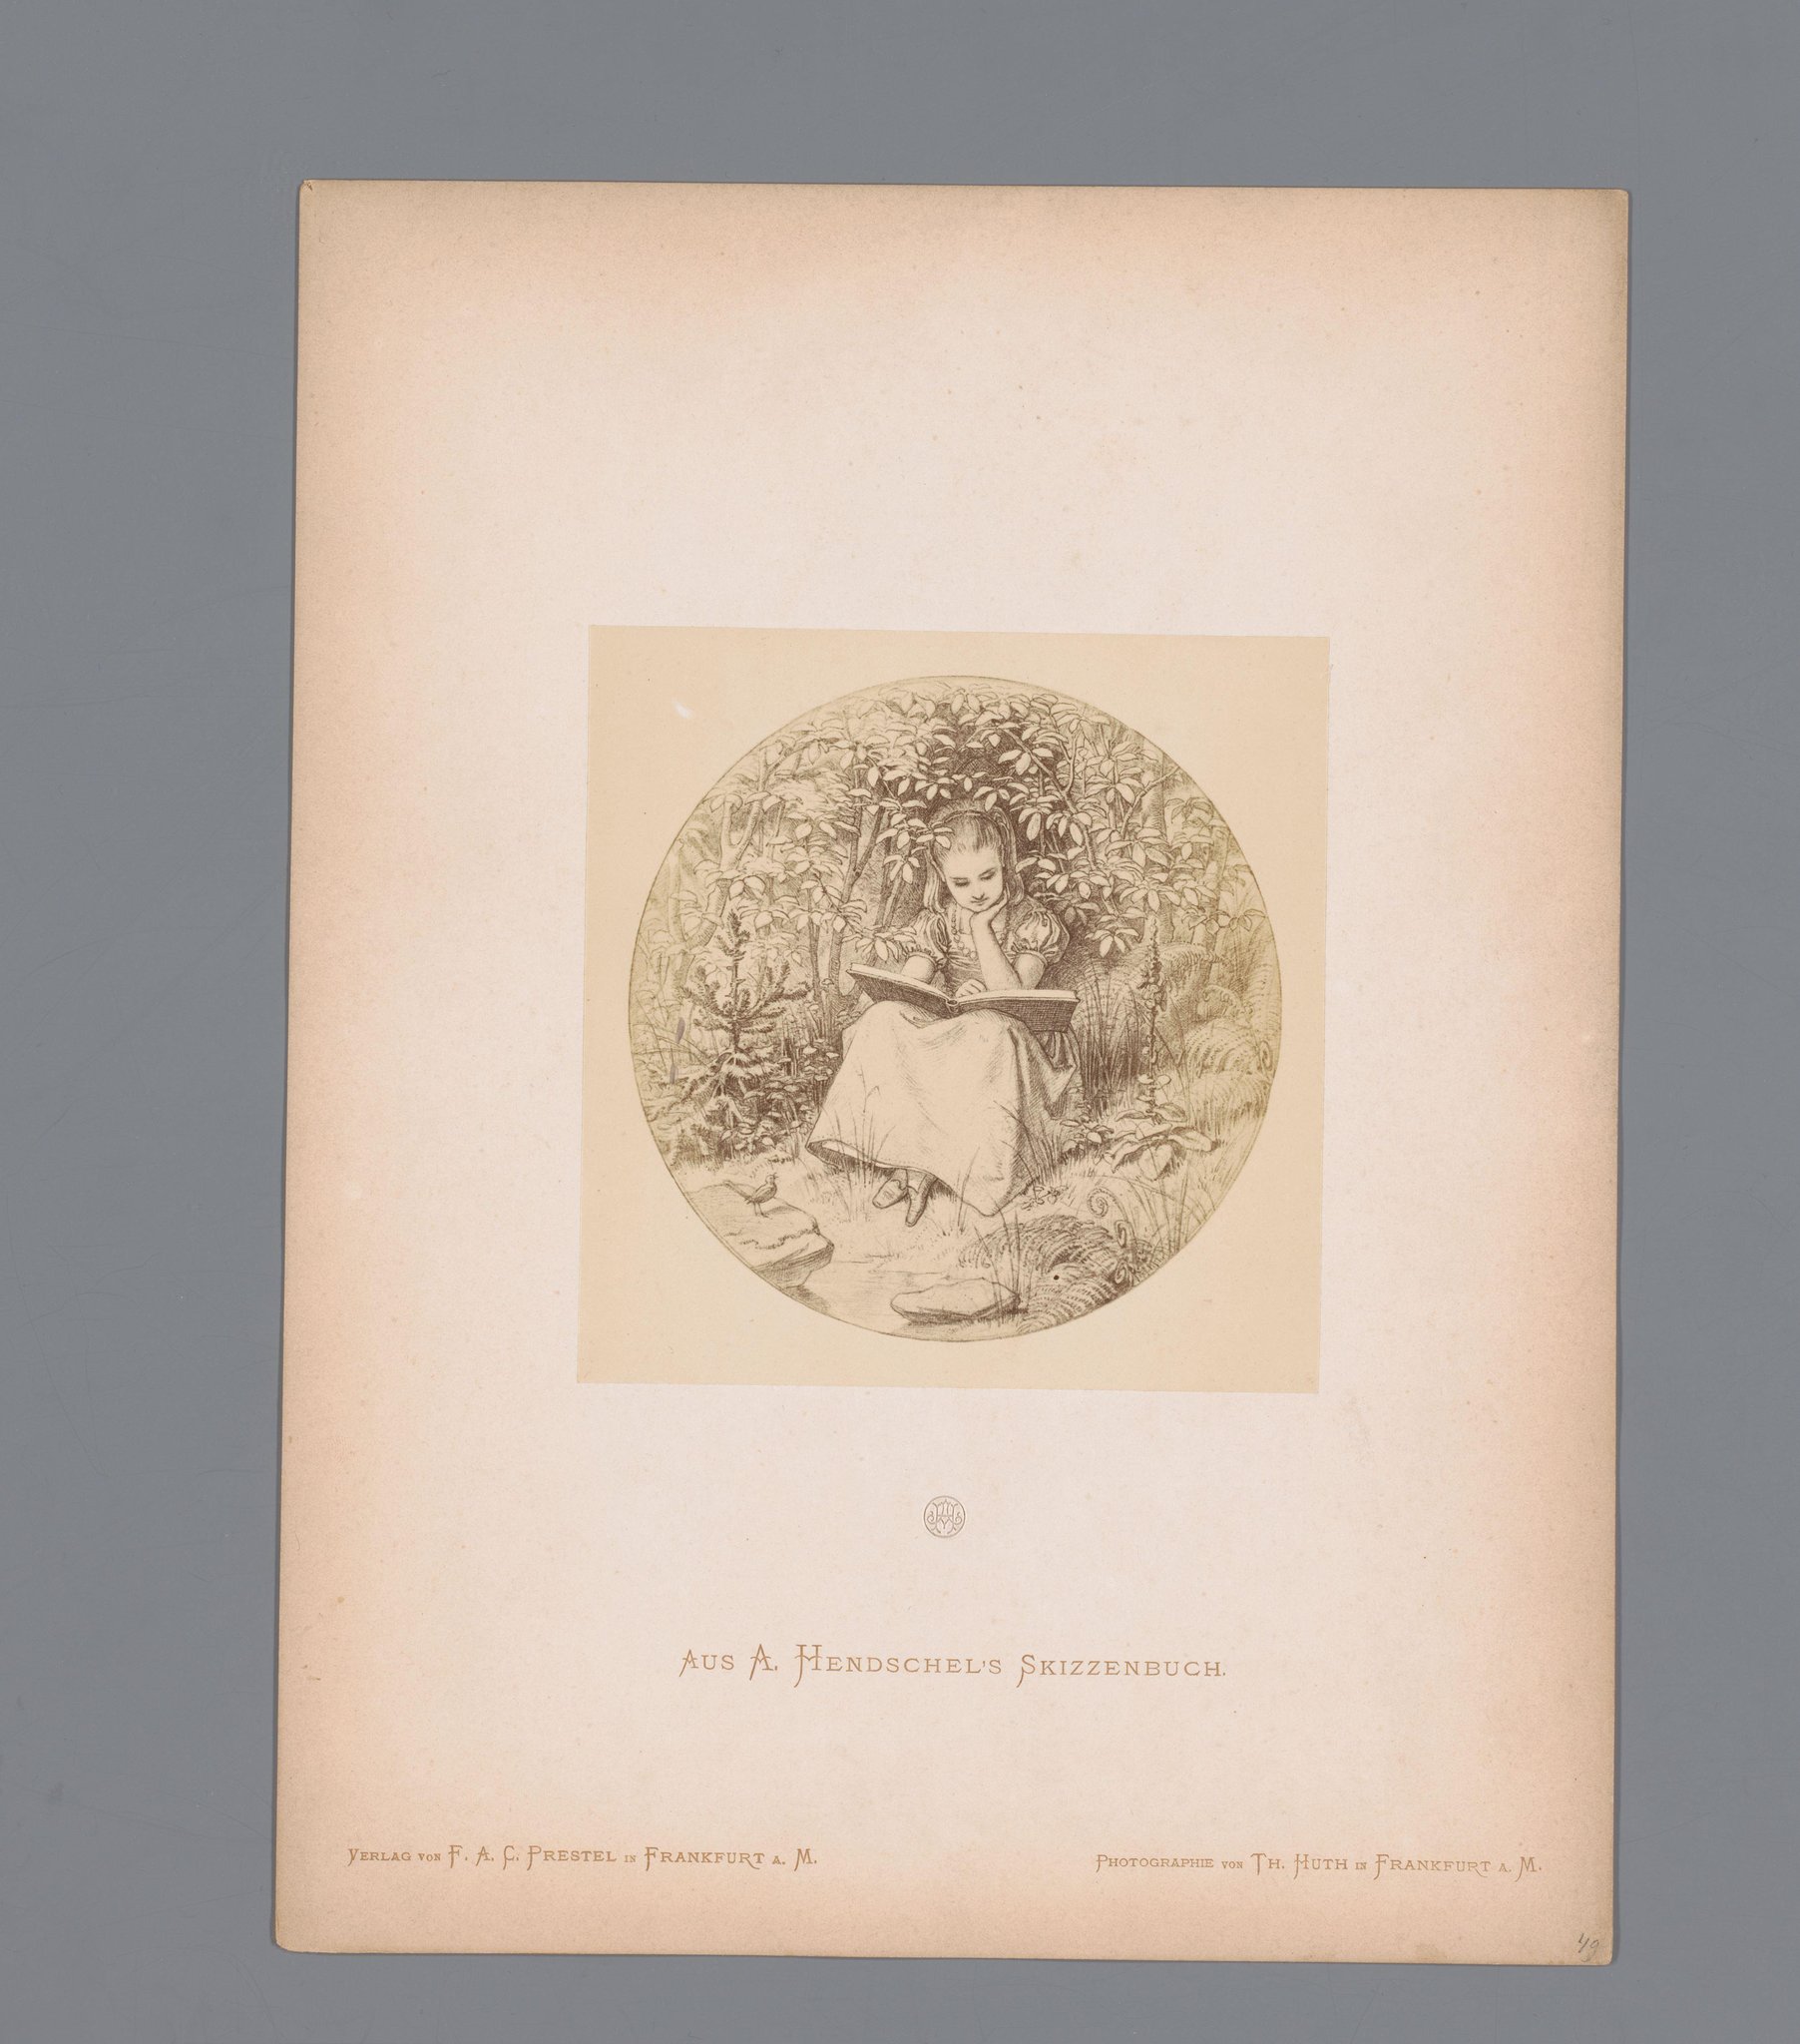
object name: reproduction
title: Fotoreproductie van een schets van een meisje dat een boek leest, door Albert Hendschel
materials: photographic support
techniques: albumen print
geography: frankfurt am main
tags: reading, girl (child between toddler and youth)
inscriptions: number: ‘49’, monogram: ‘AH’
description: Deze foto maakt deel uit van een omslag met 50 foto's op 48 bladen, een lijst van afbeeldingen en een titelblad.